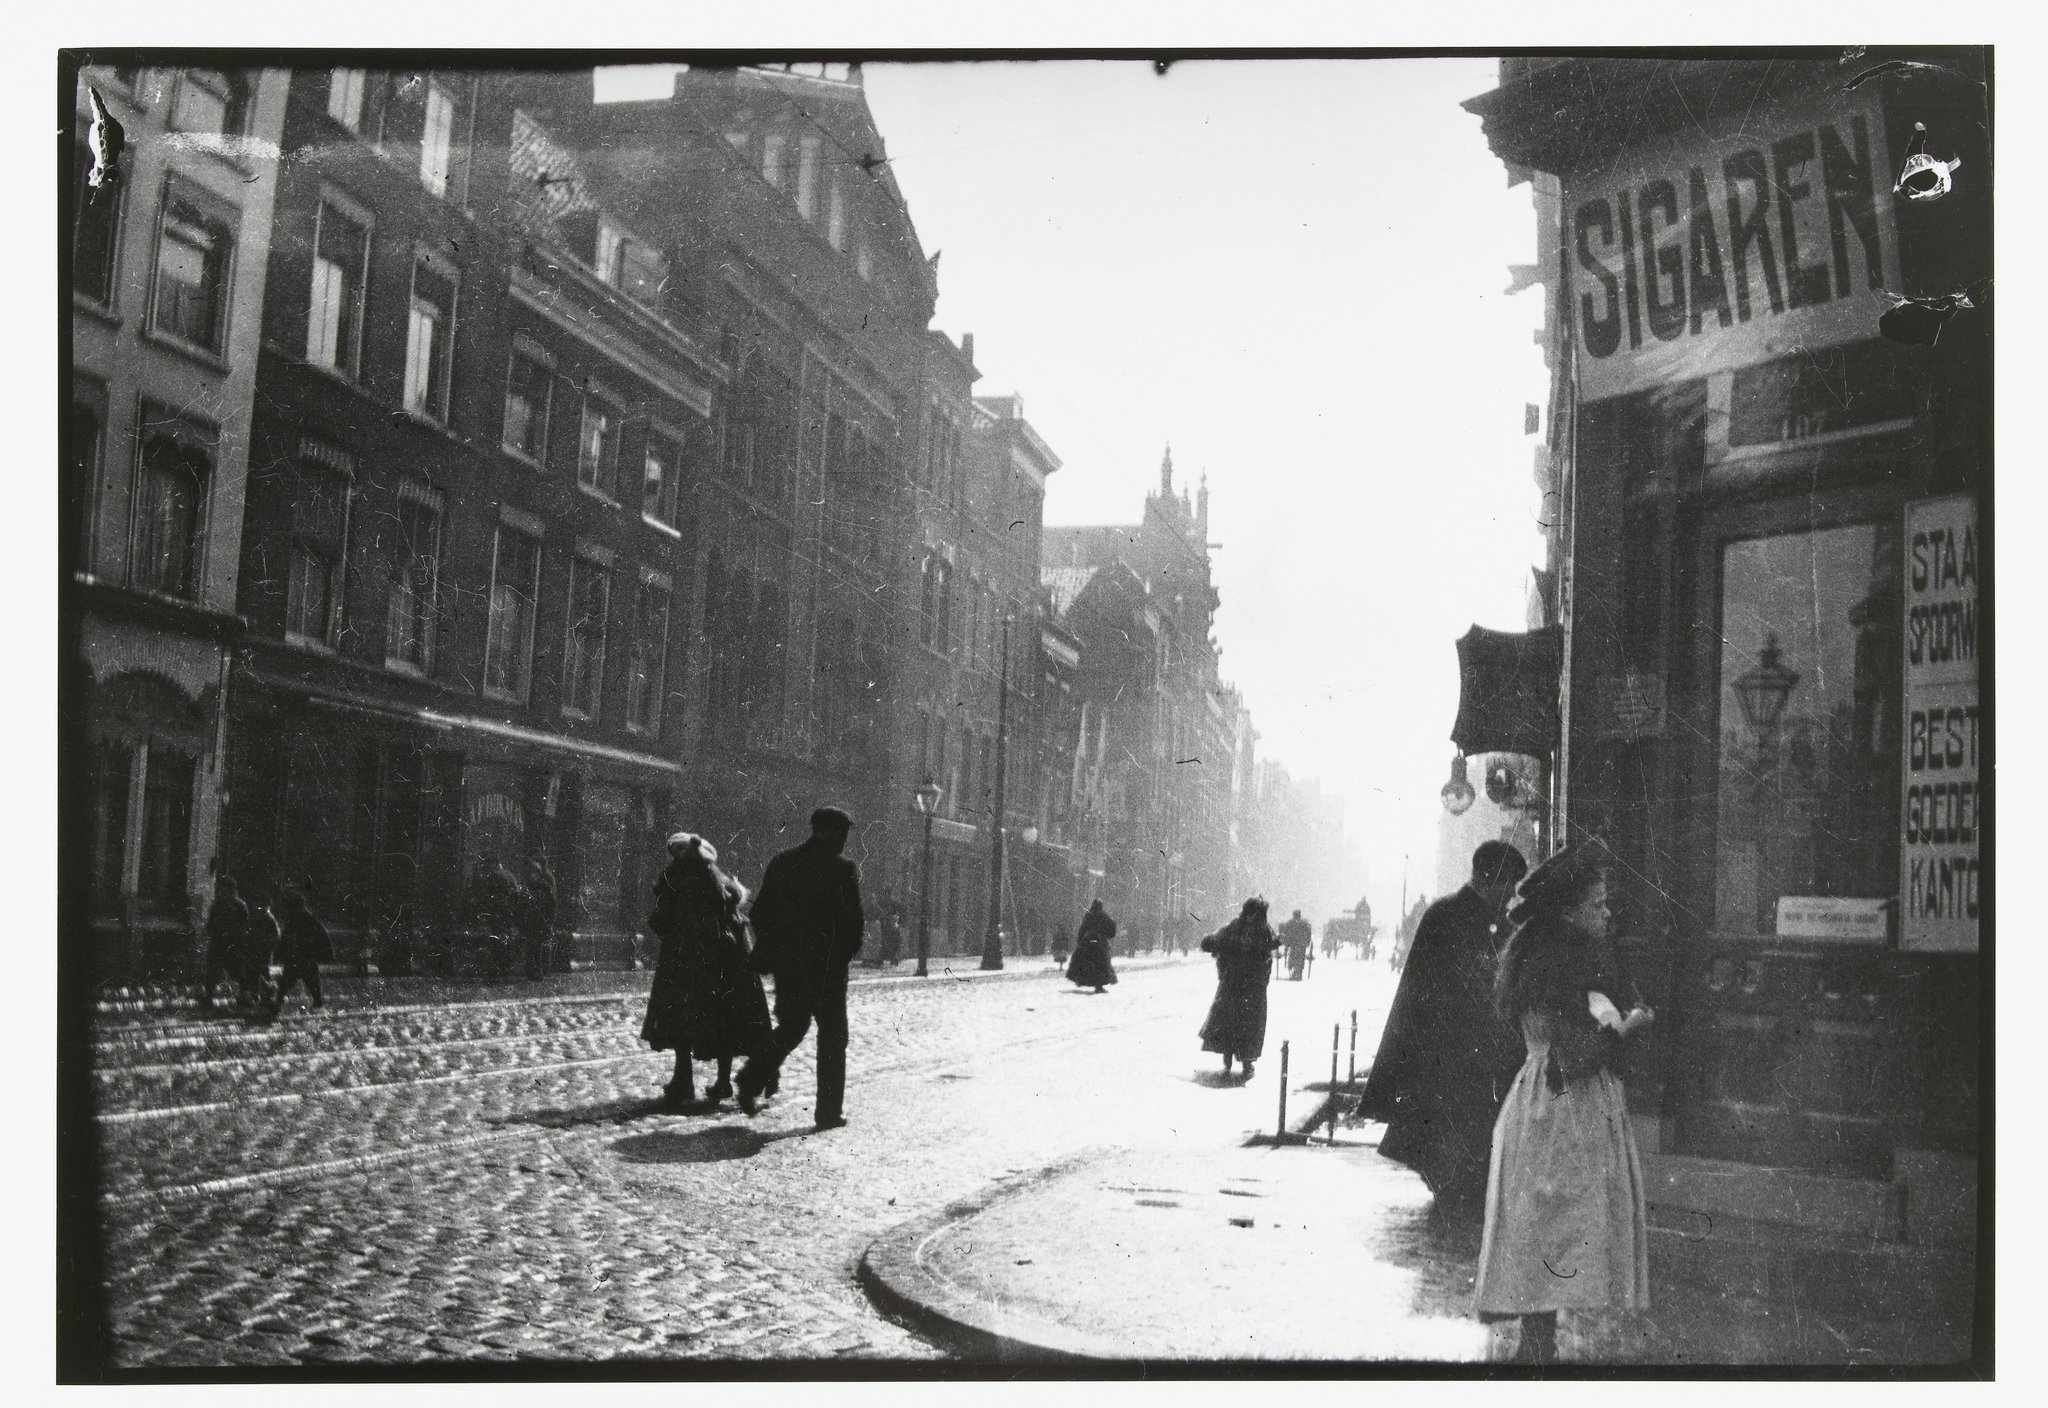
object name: photograph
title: Straatgezicht in Rotterdam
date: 1890-1910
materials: paper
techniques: gelatin silver print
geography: netherlands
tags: rotterdam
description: Moderne afdruk van negatief BR 1323 (collectie RKD).